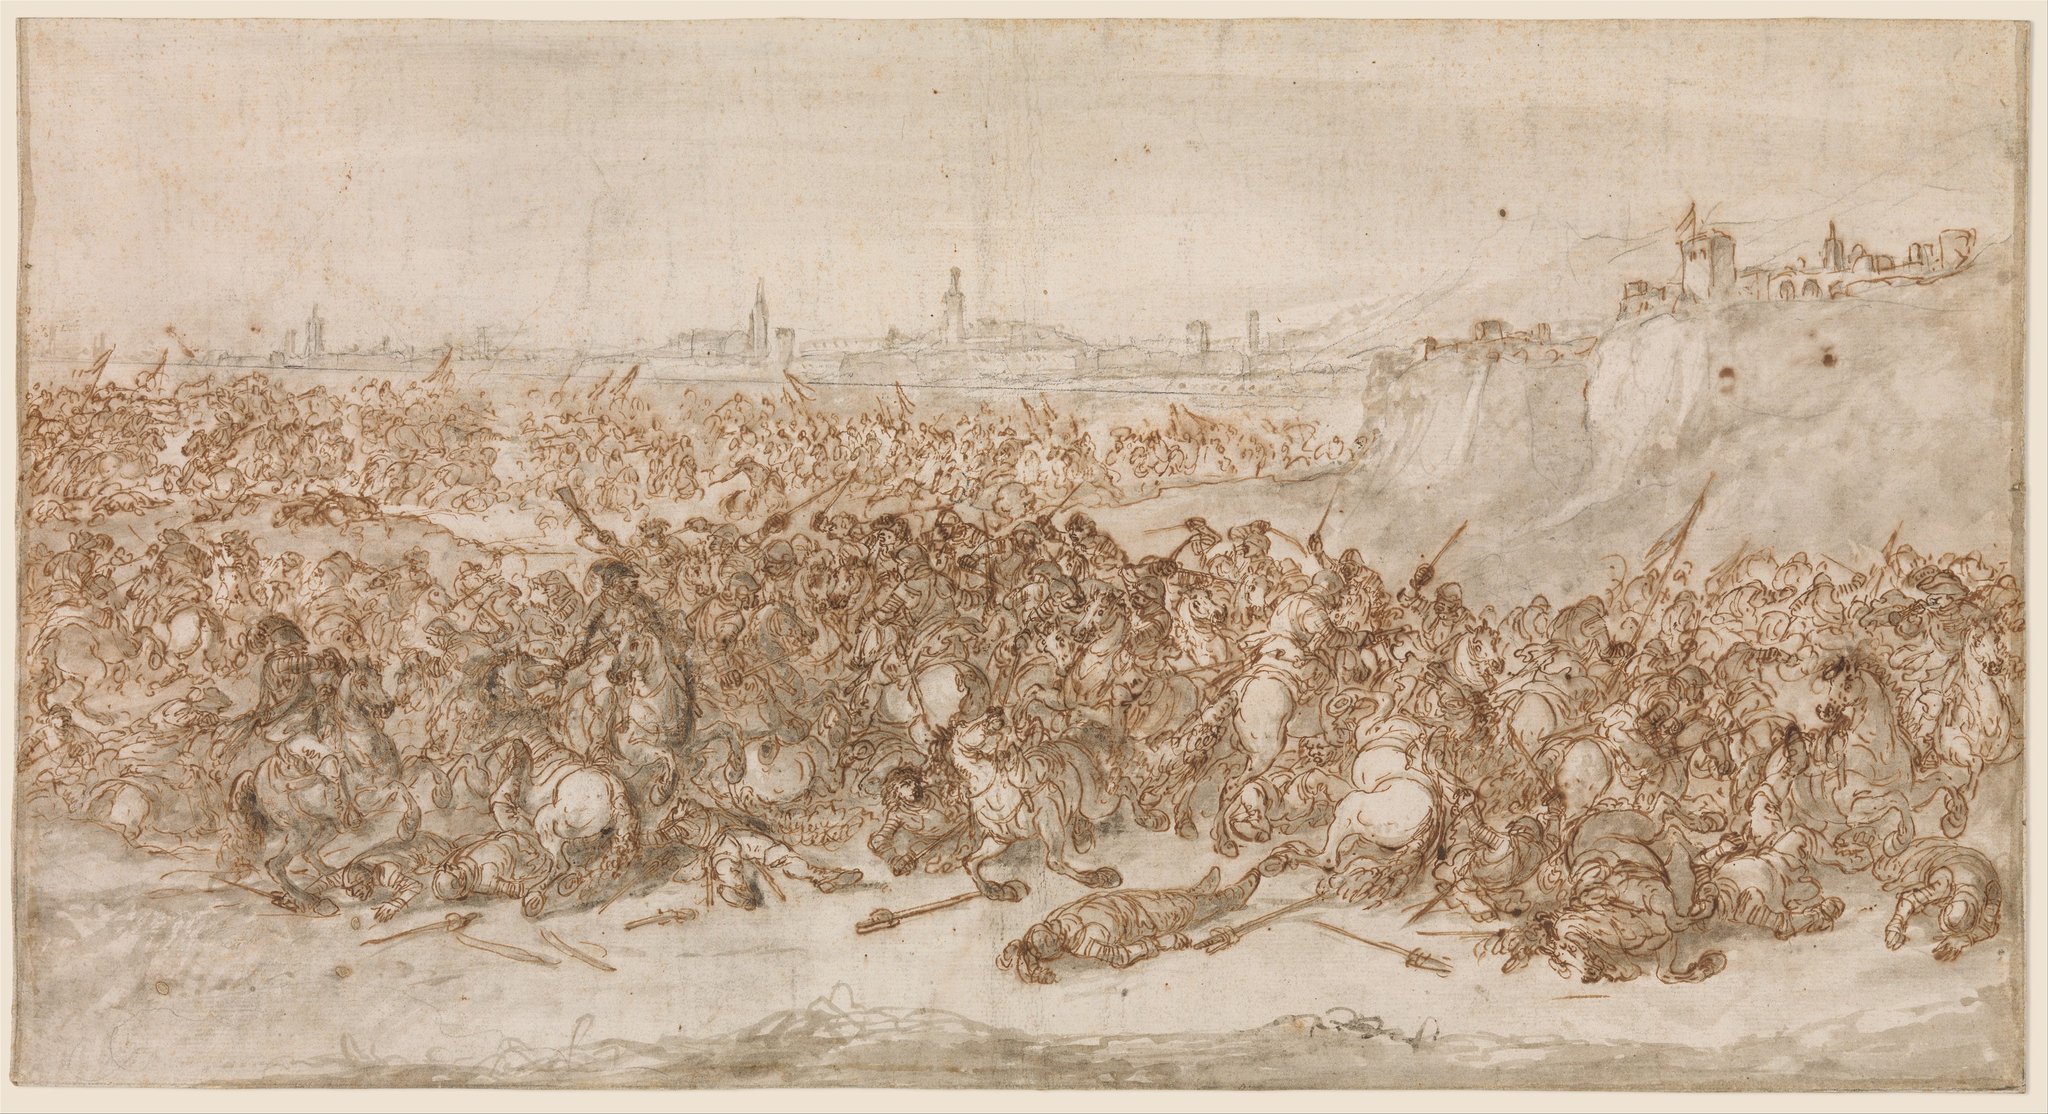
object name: drawing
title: A Cavalry Battle before a City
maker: francesco antonio simonini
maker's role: artist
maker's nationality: italian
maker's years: 1686-1755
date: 1686-1755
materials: chalk, ink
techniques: brush, pen, wash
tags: battles,soldiers,horses